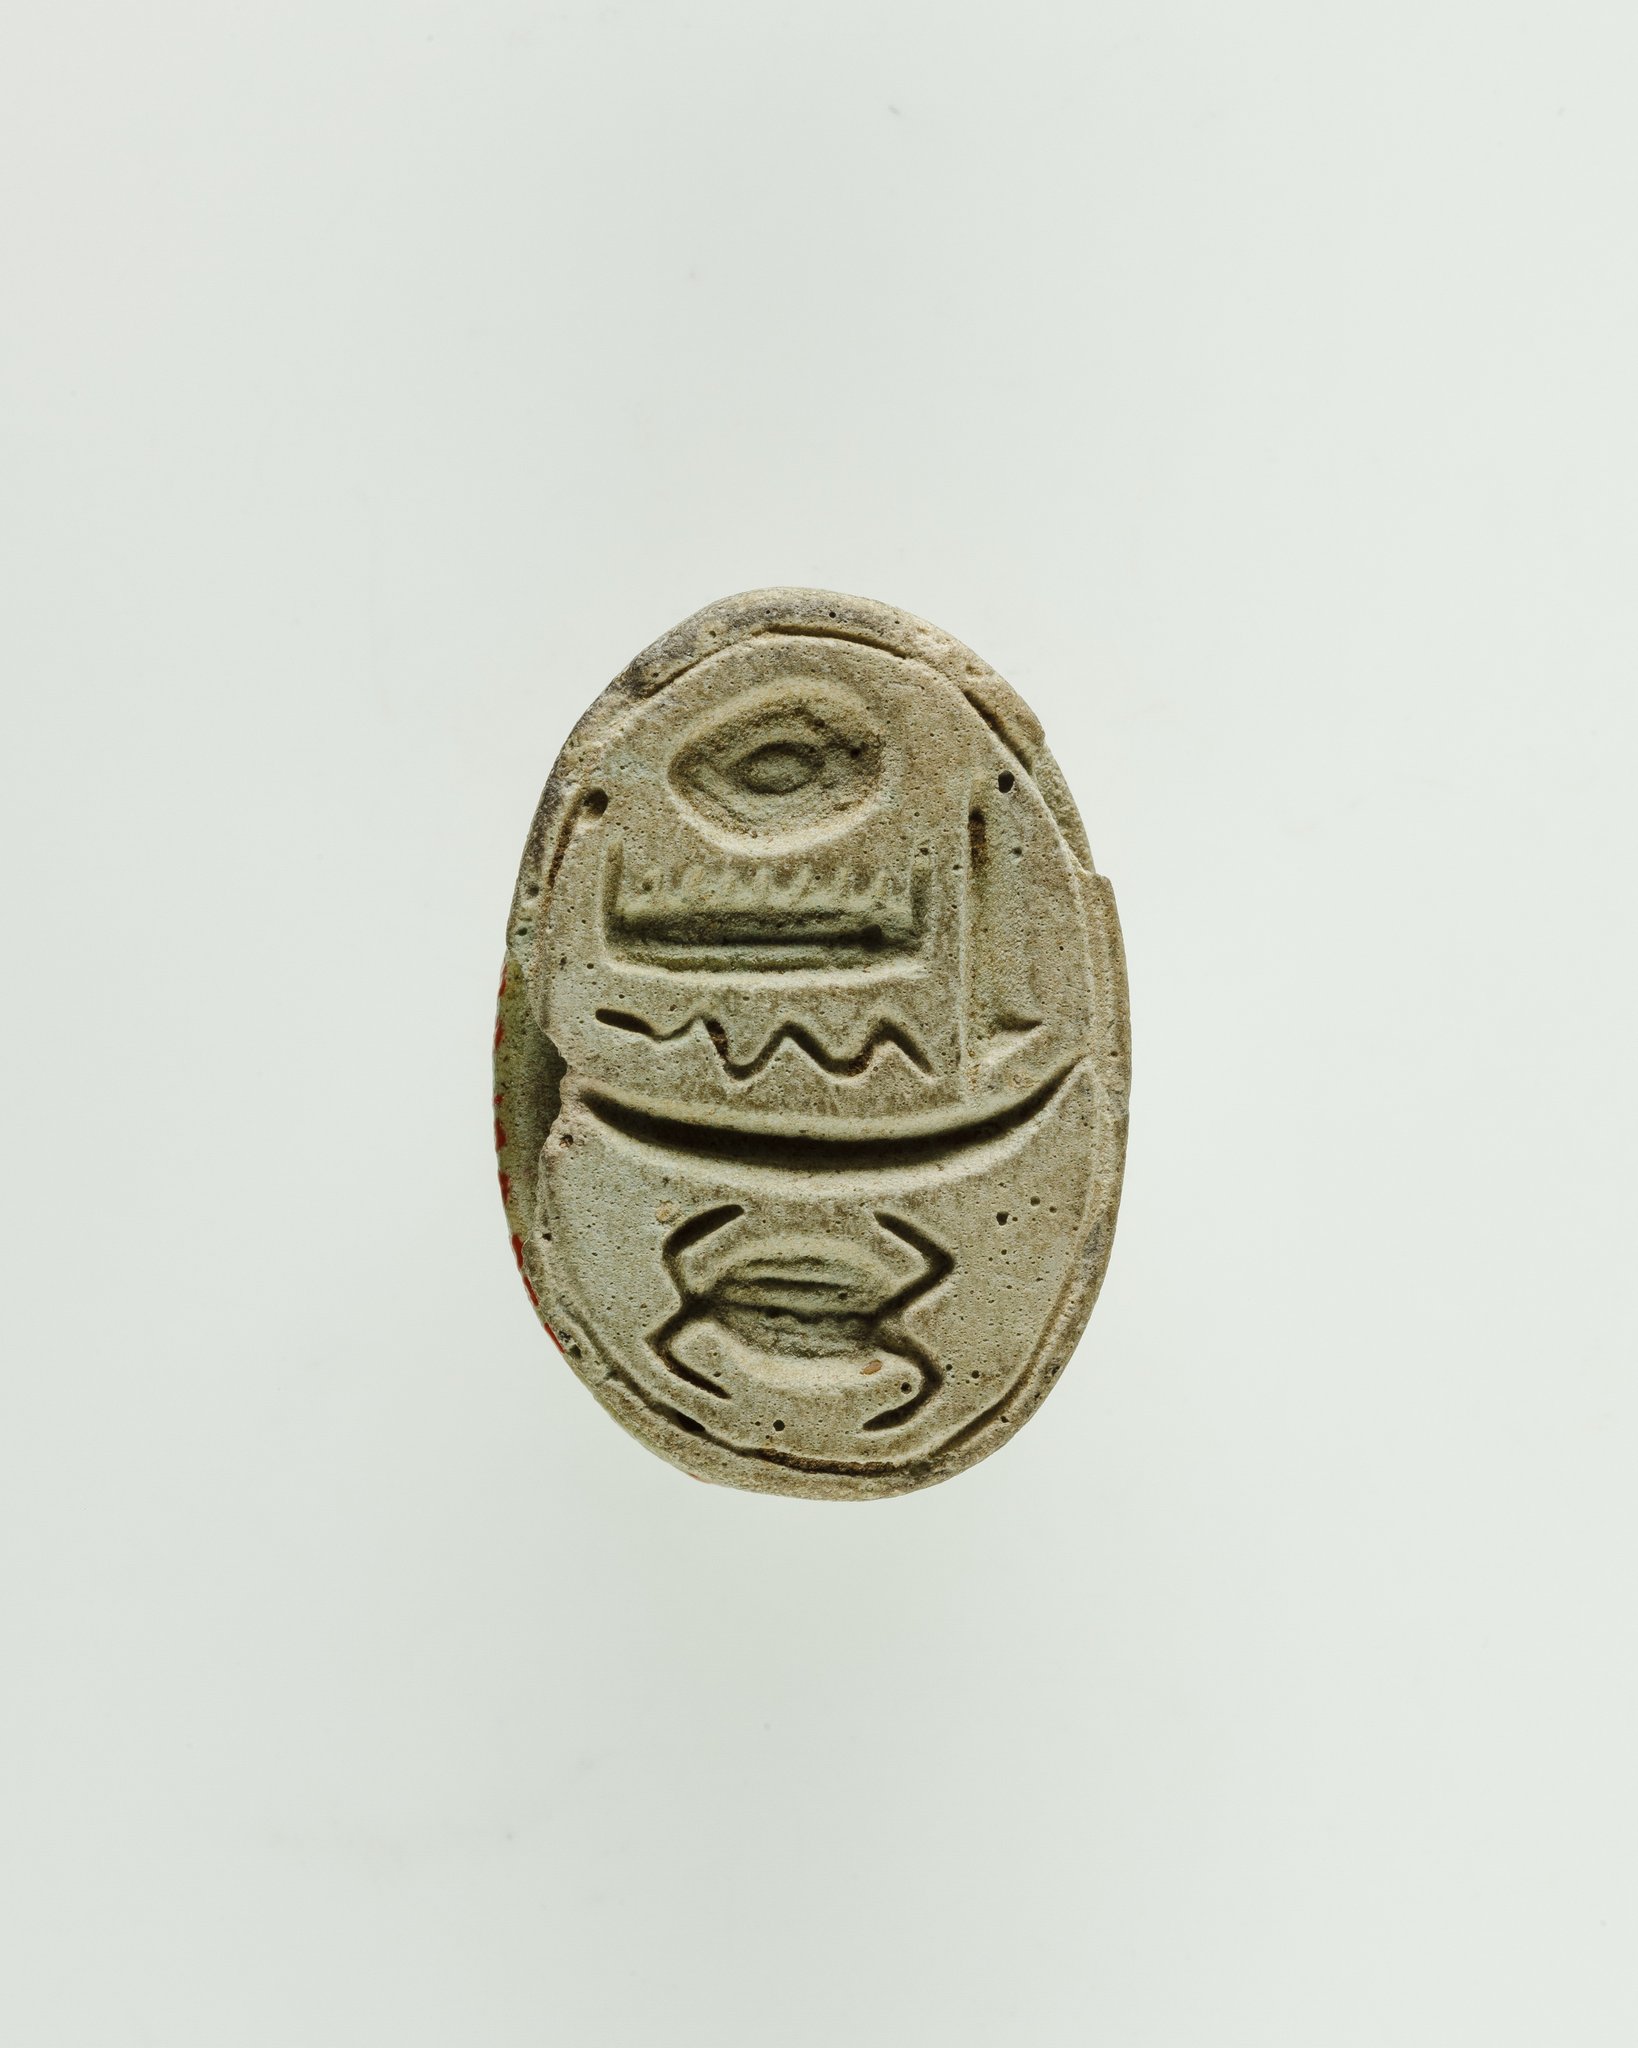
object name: scarab, amun re, neit symbol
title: Scarab Inscribed with the Names of Amun-Re and Neit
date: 1295-1070 BCE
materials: faience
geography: egypt